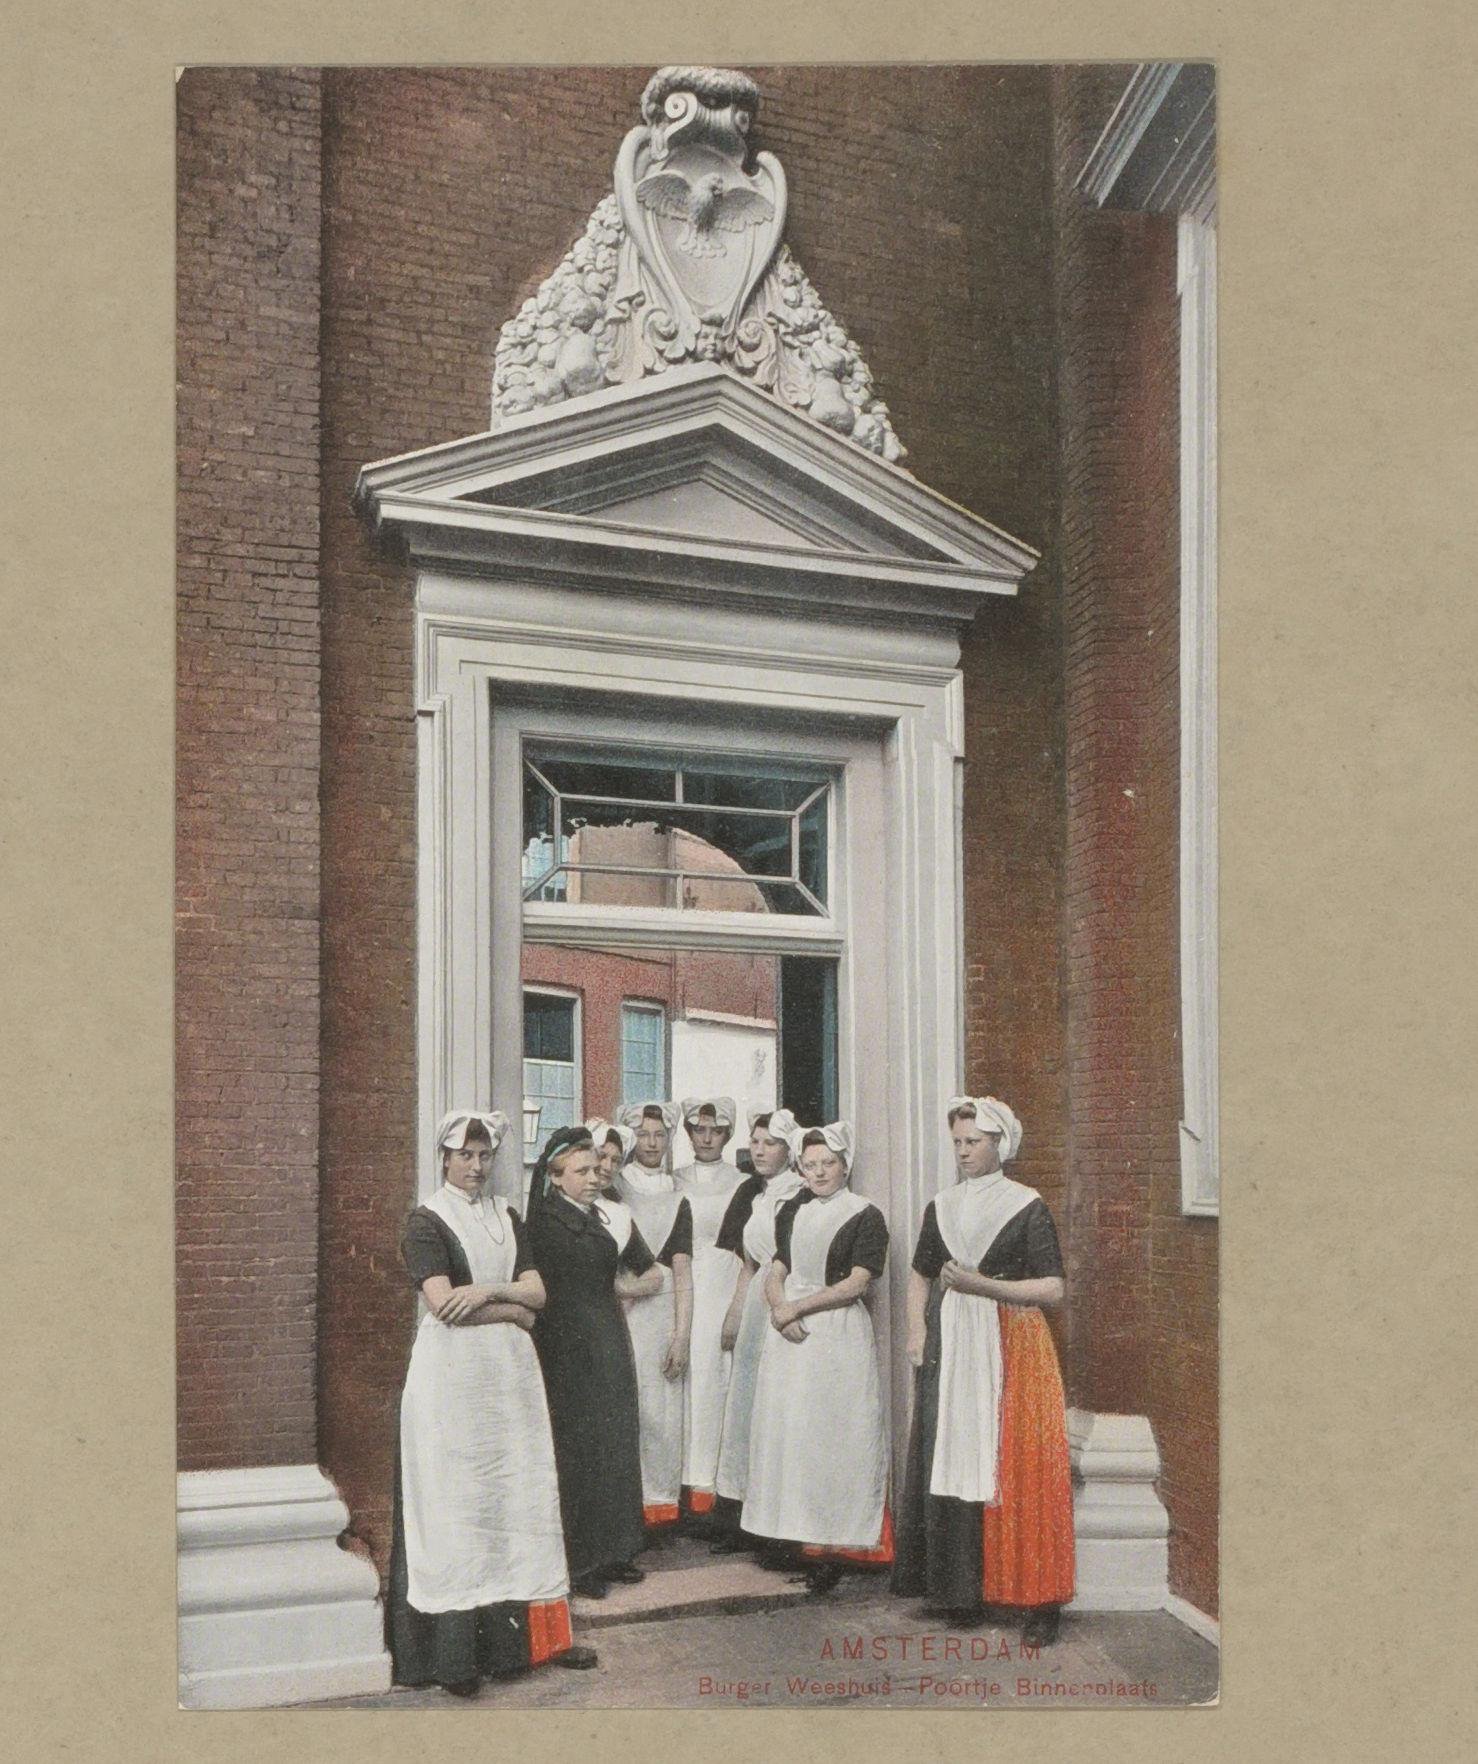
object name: ansichtkaart, prentbriefkaart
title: Weesmeisjes voor de poort op de binnenplaats van het Burgerweeshuis te Amsterdam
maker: Anonymous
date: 1890-1920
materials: cardboard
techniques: four-color autotype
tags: orphanage, orphans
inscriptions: collector's mark: Lugt 1641b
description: Onderwerpsrubriek binnen de Atlas Amsterdam: Armwezen en liefdadige instellingen: I. Stadsinrichtingen: Burgerweeshuis.